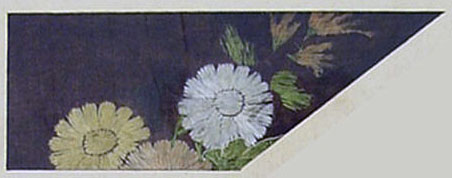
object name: piece from a summer kosode katabira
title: Piece from a Kosode with Chrysanthemums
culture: japanese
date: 1615-1868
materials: fiber, silk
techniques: embroidery, weave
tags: flowers